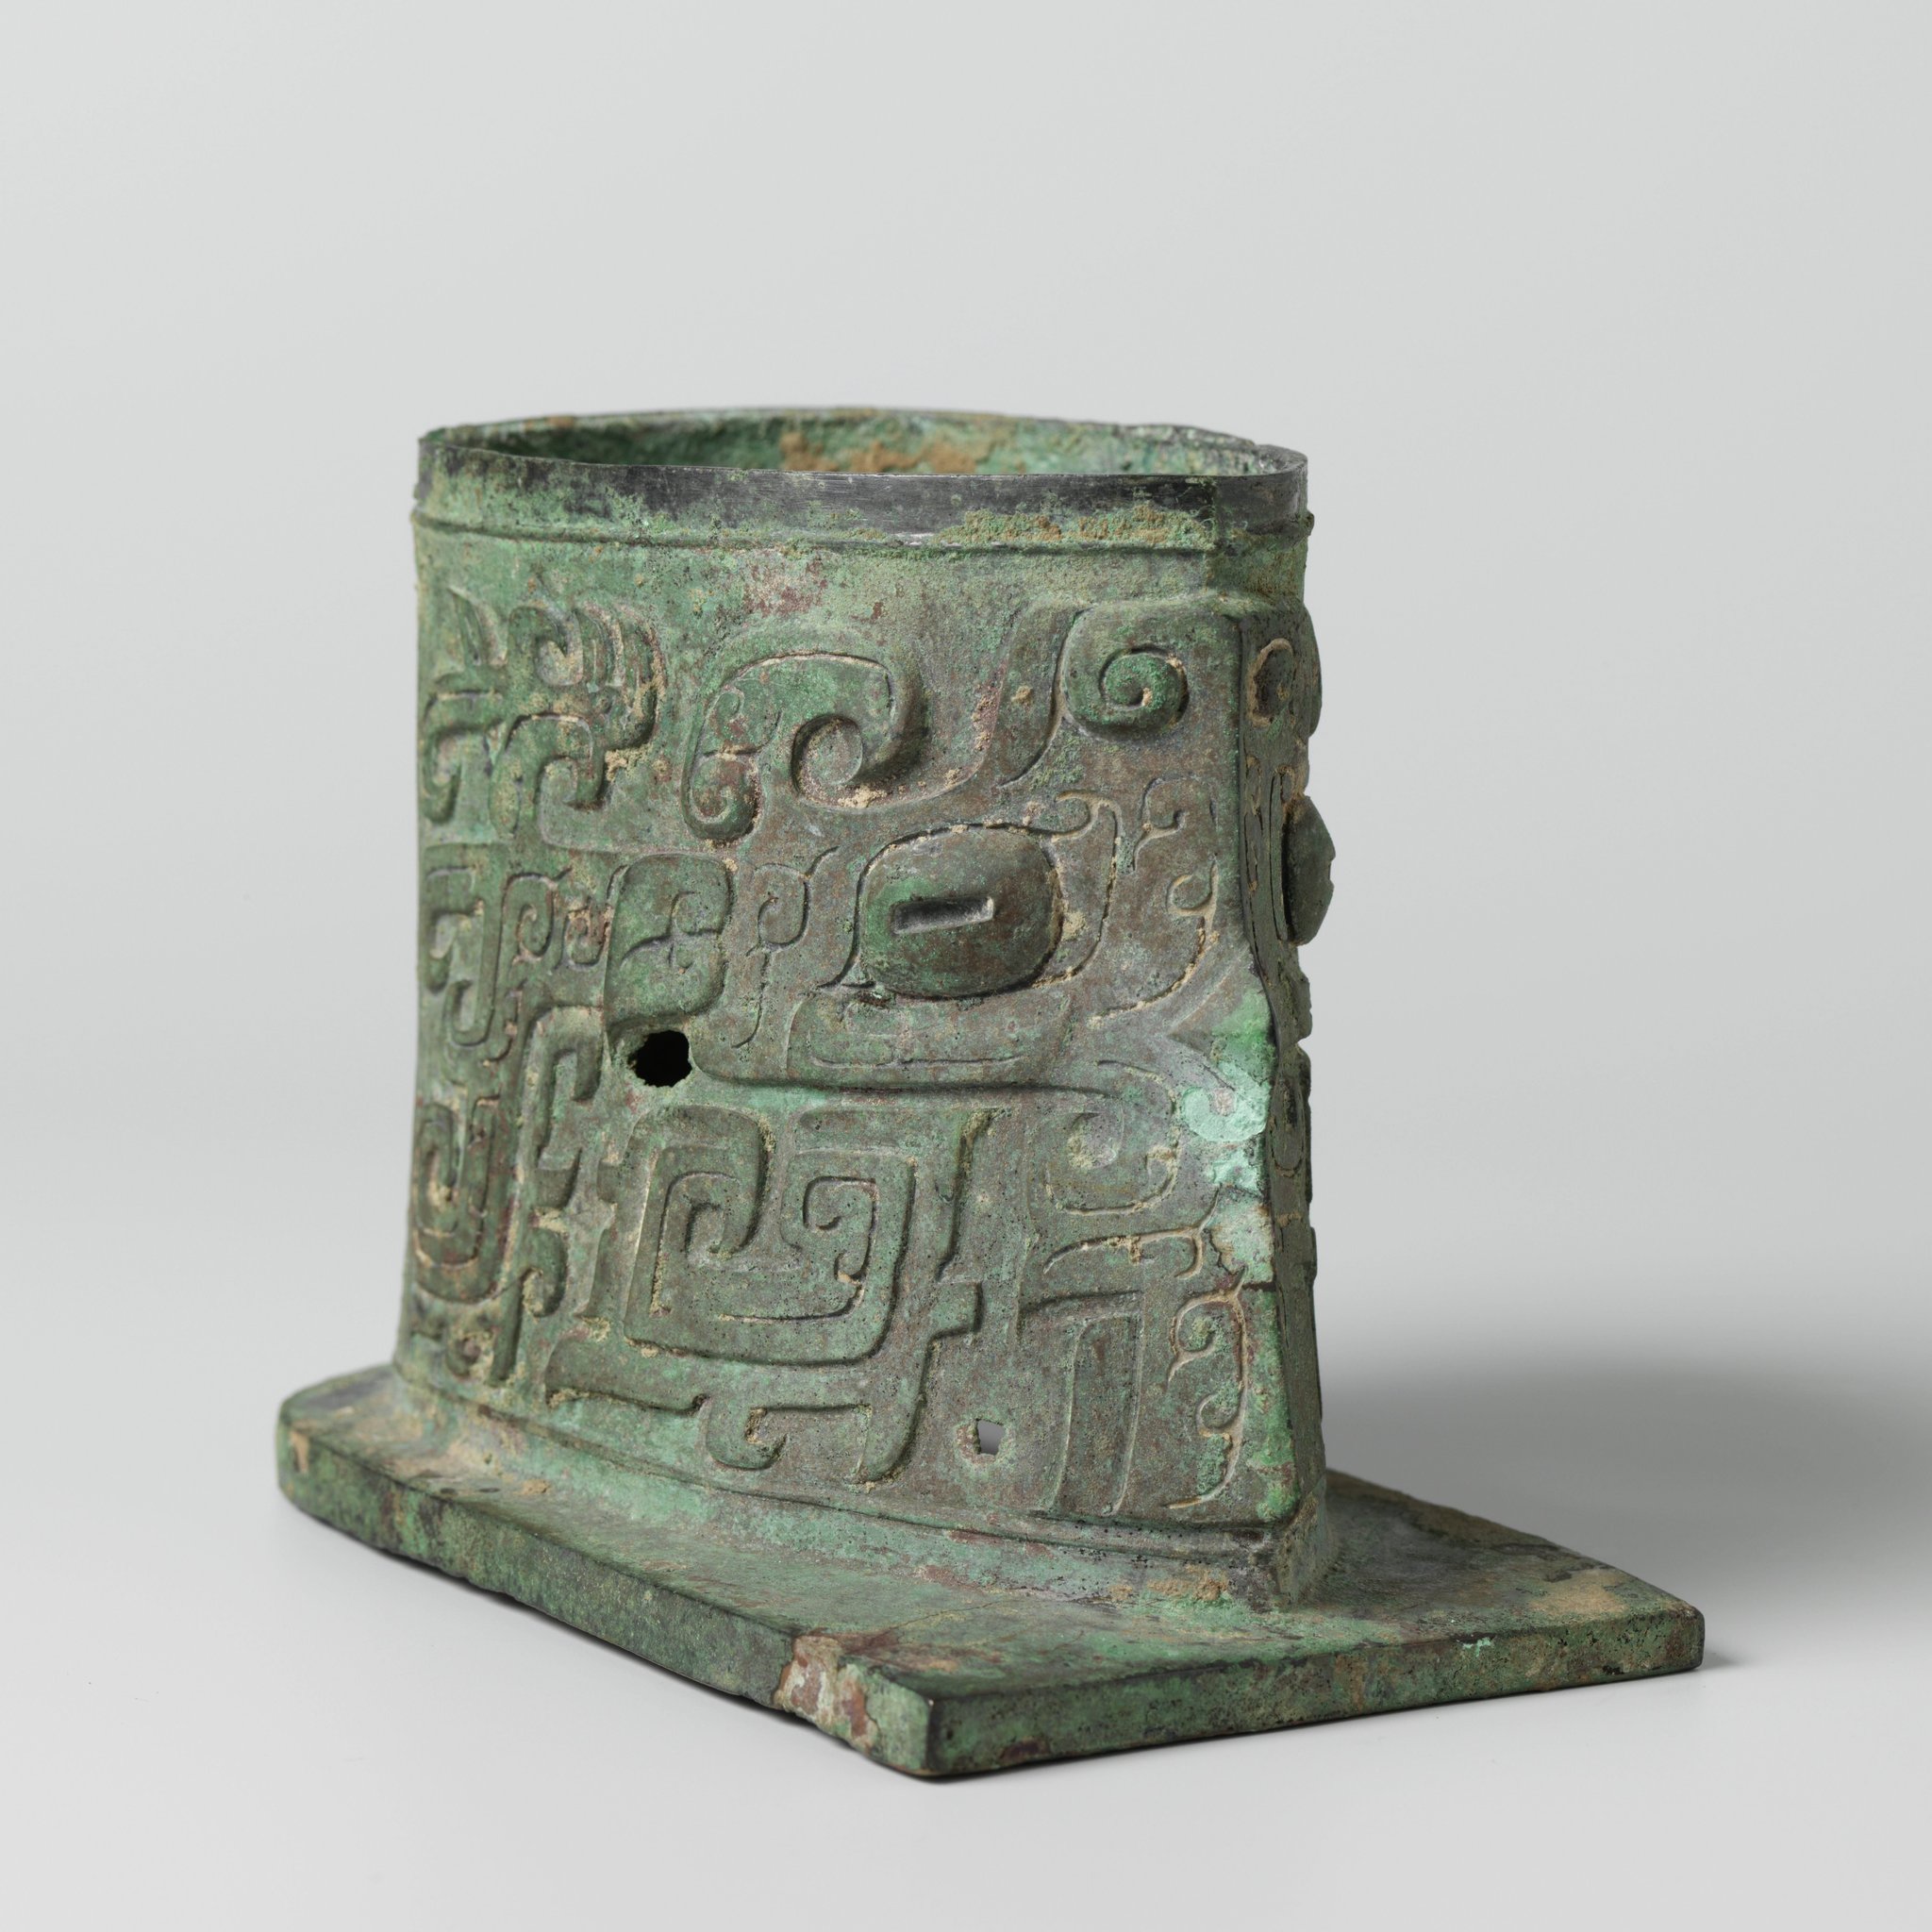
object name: architectural element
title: Fragment of a Chariot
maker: Anonymous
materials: bronze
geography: china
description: This fragment is part of a chariot and served to connect the axle to the wheel. Adorned with the mask of a mythical animal known as a taotie, its distinctiveness lies in the presence of the eyes on either side. The impeccable artistry evident in both the casting and the carving of the bronze attests to the high status held by the chariot's owner.